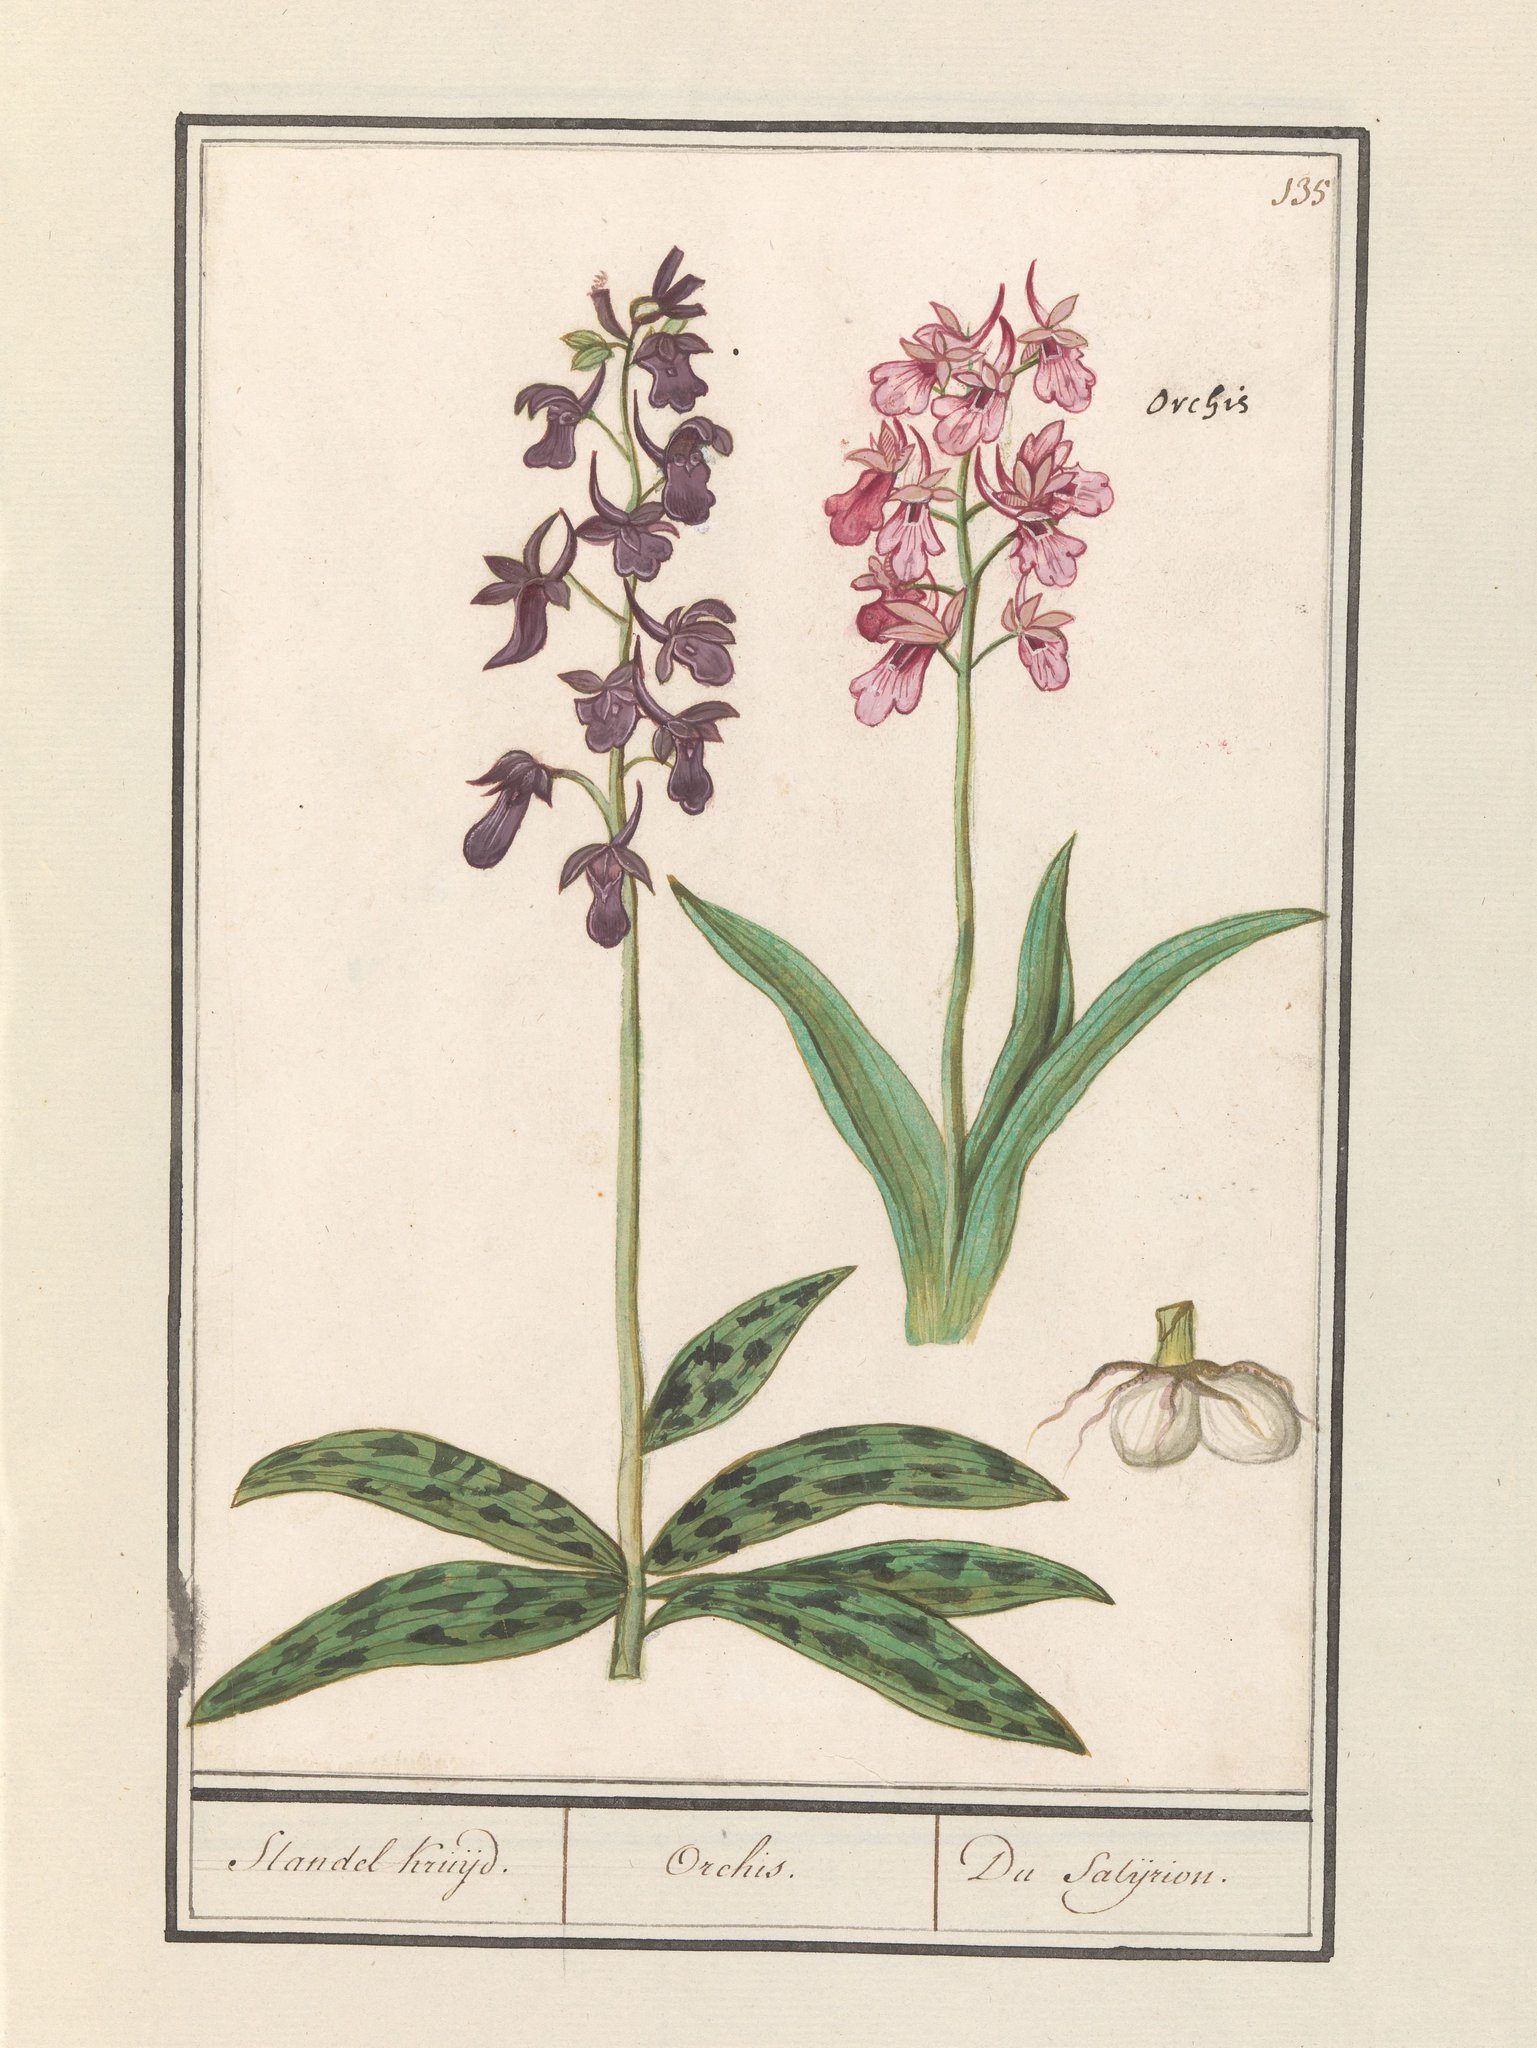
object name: drawing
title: Standel Kruijd. / Orchis. / Du Satijrion.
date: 1596-1610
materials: chalk, paint, ink, paper, watercolor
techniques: brush, pen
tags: flowers: orchid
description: Twee orchideeën. Rechtsboven genummerd: 135. Rechtsboven de Latijnse naam. Onderdeel van het tweede album met tekeningen van bloemen en planten. Negende van twaalf albums met tekeningen van dieren, vogels en planten bekend rond 1600, gemaakt in opdracht van keizer Rudolf II. Met toelichting in Nederlands, Latijn en Frans.